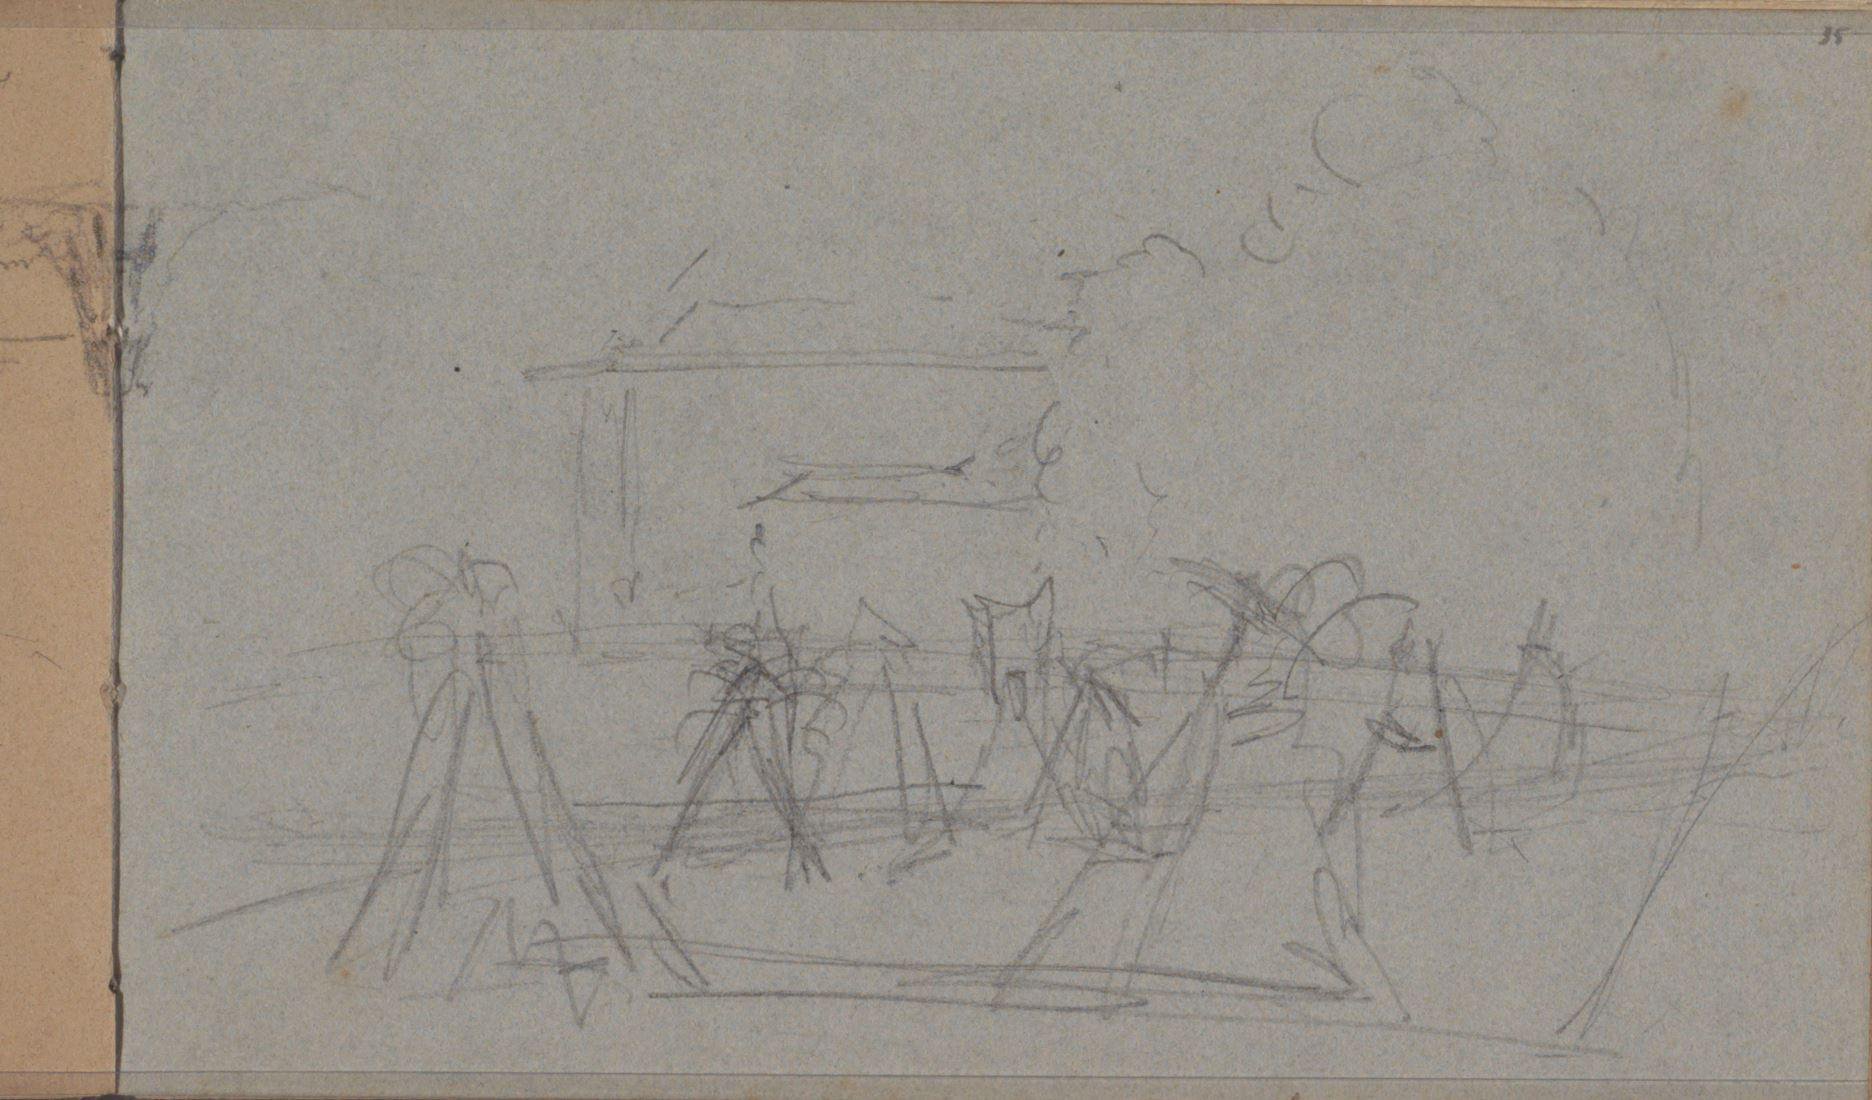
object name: sketchbook leaf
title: Veld met korenschoven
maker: maria vos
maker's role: draughtsman, painter, print maker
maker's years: 1824-1906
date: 1863-1864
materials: paper, pencil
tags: sheaf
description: Blad 35 recto uit een schetsboek met 41 bladen.